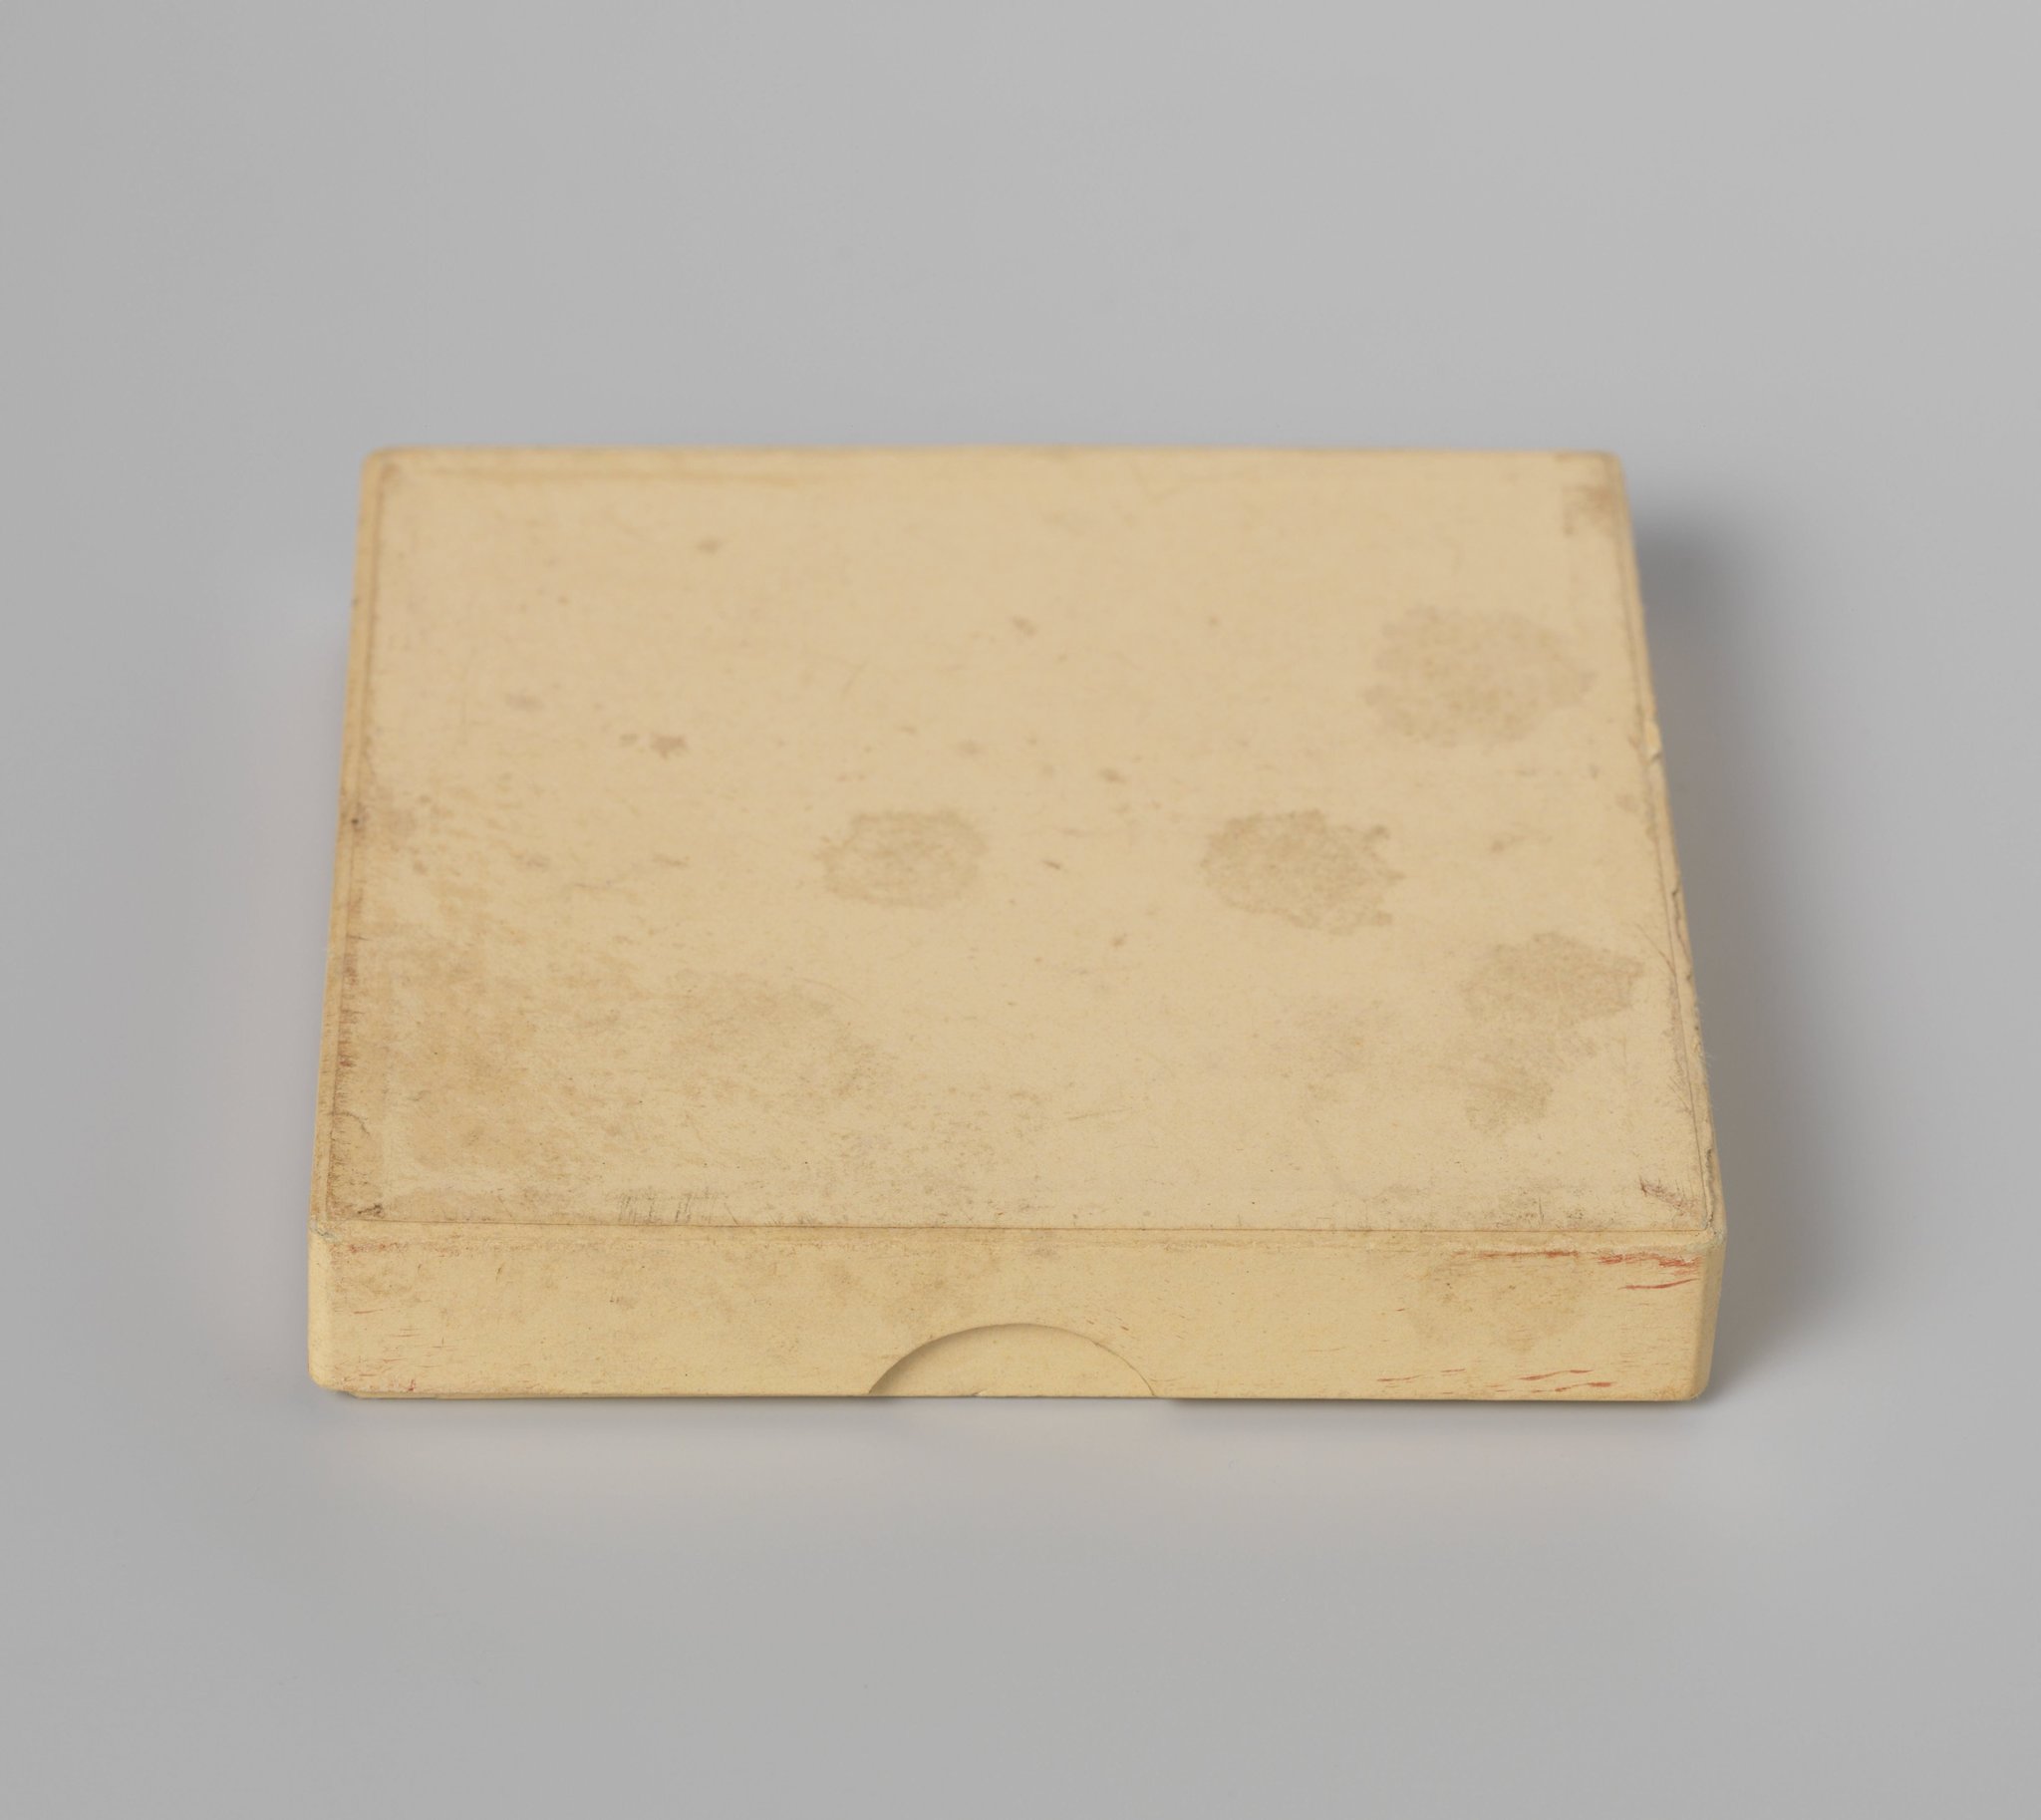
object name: medal box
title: Penningdoos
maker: johannes cornelis wienecke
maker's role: medailleur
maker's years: 1872-1945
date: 1919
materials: cardboard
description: Originele doos horend bij een gouden penning (NG-C-2016-1-1).